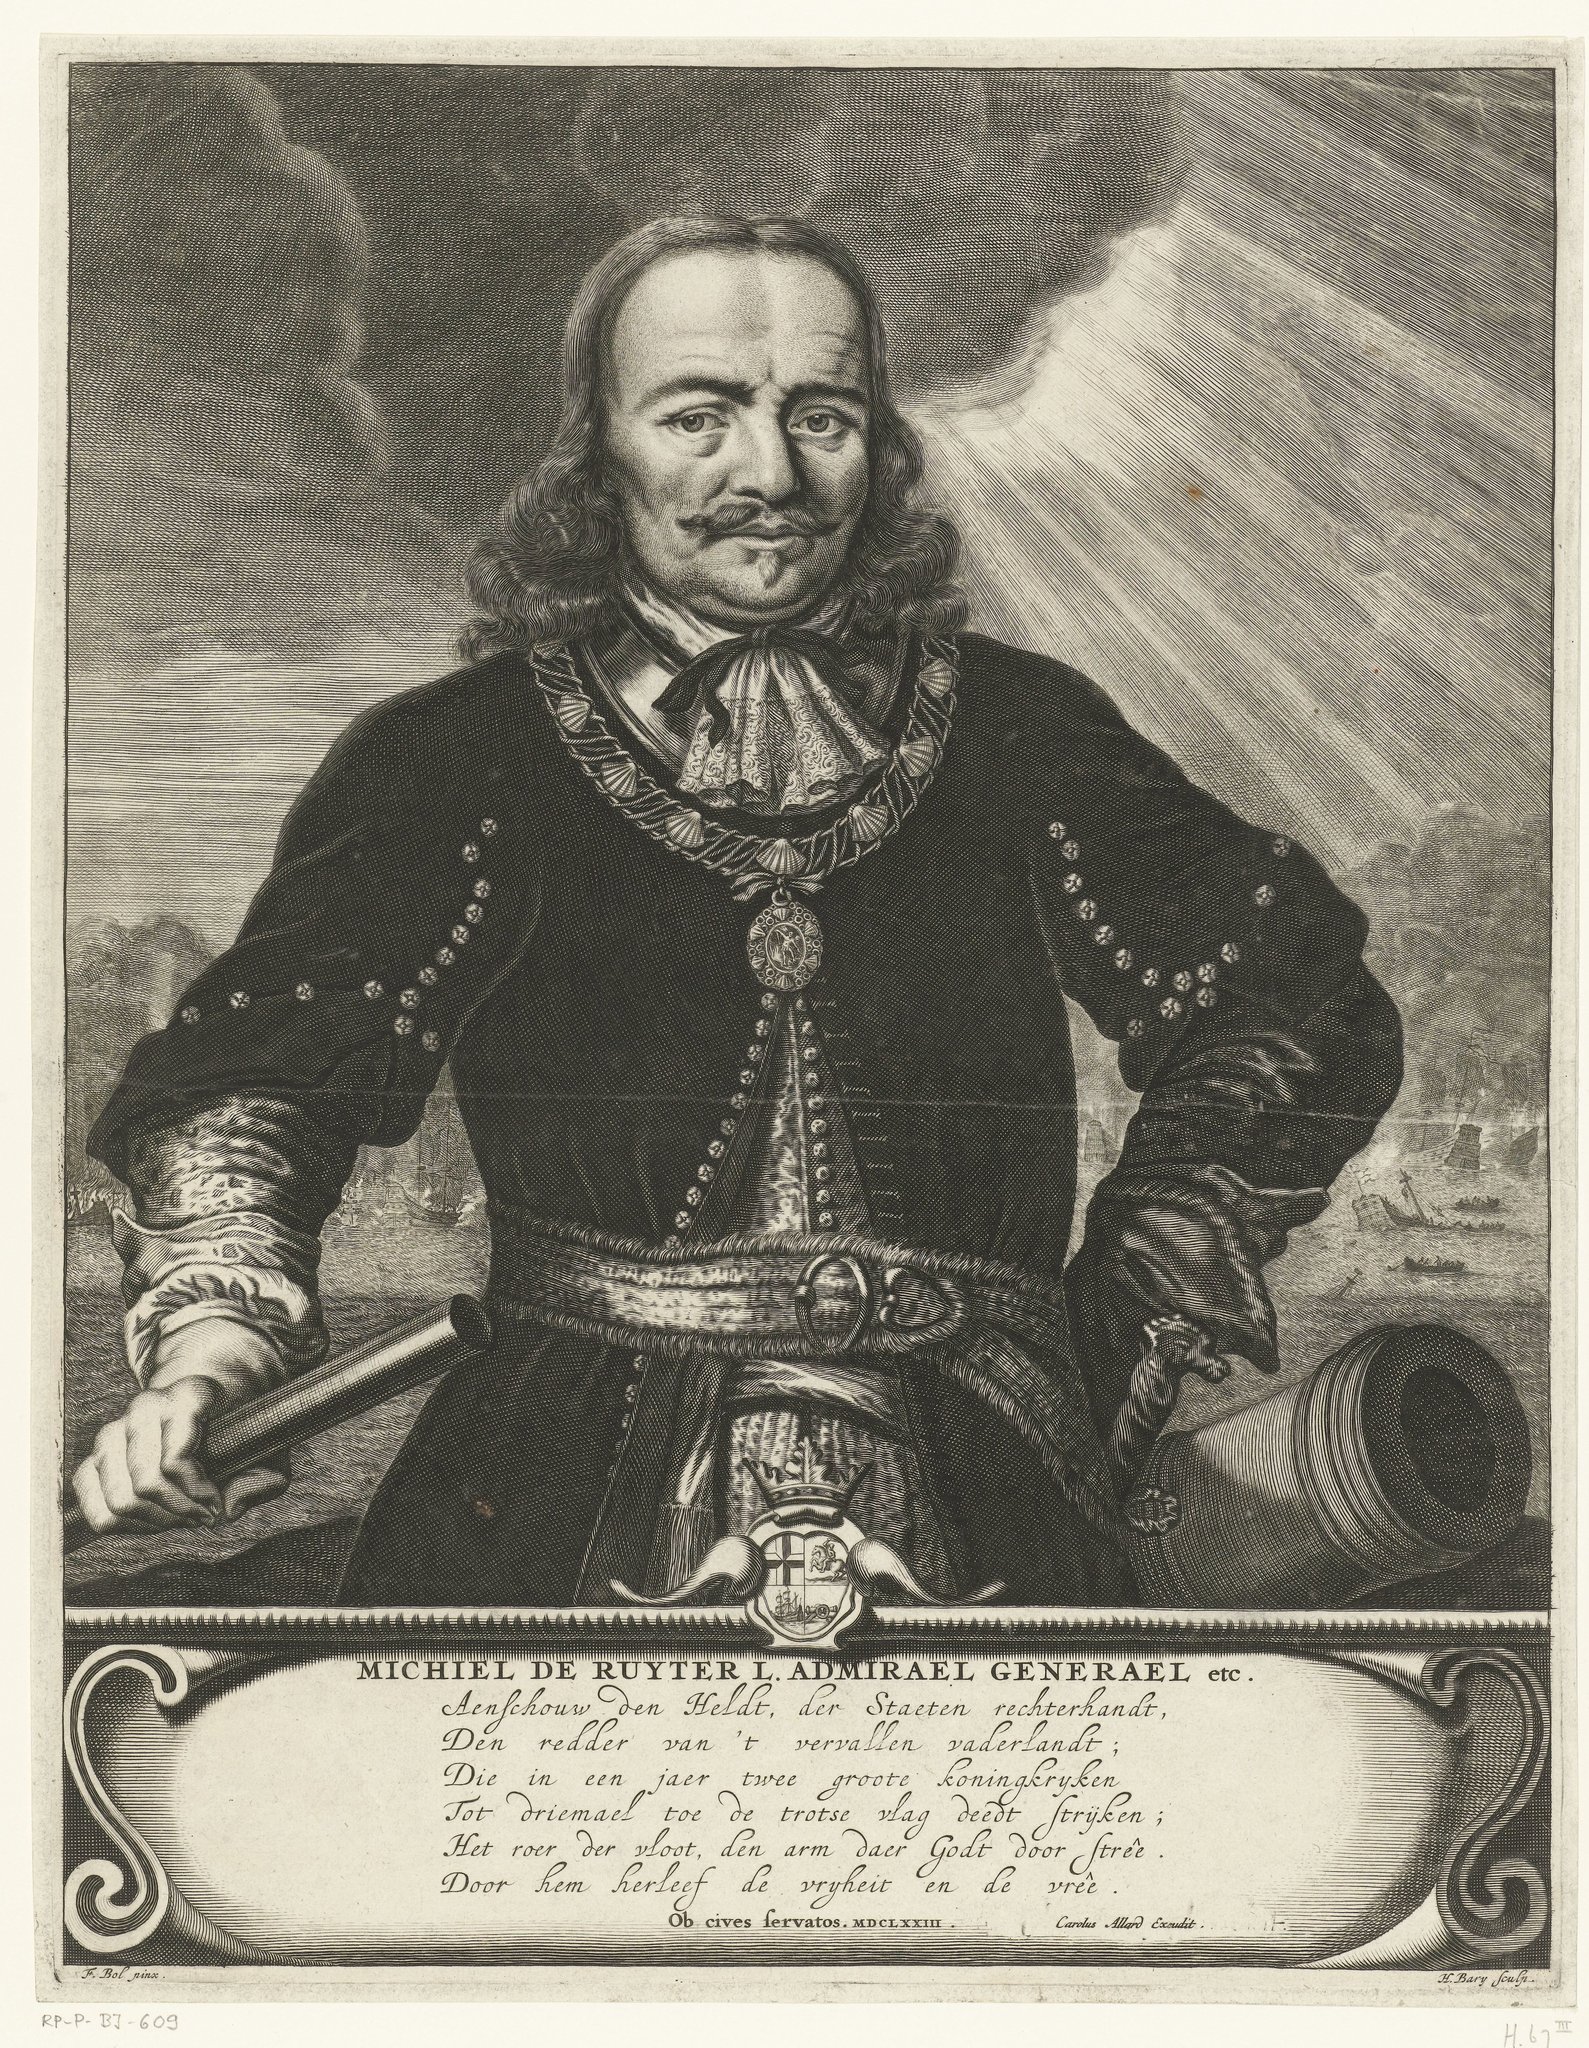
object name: print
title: Portret van Michiel Adriaenszoon de Ruyter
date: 1673-1707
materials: paper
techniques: engraving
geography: amsterdam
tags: flushing, michiel adriaenszoon de ruyter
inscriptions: collector's mark: Lugt 2228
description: Portret van admiraal Michiel Adriaenszoon de Ruyter met de commandostaf in zijn hand. Op de achtergrond een zeegevecht. Onder het portret een lofdicht van zes regels in het Nederlands.